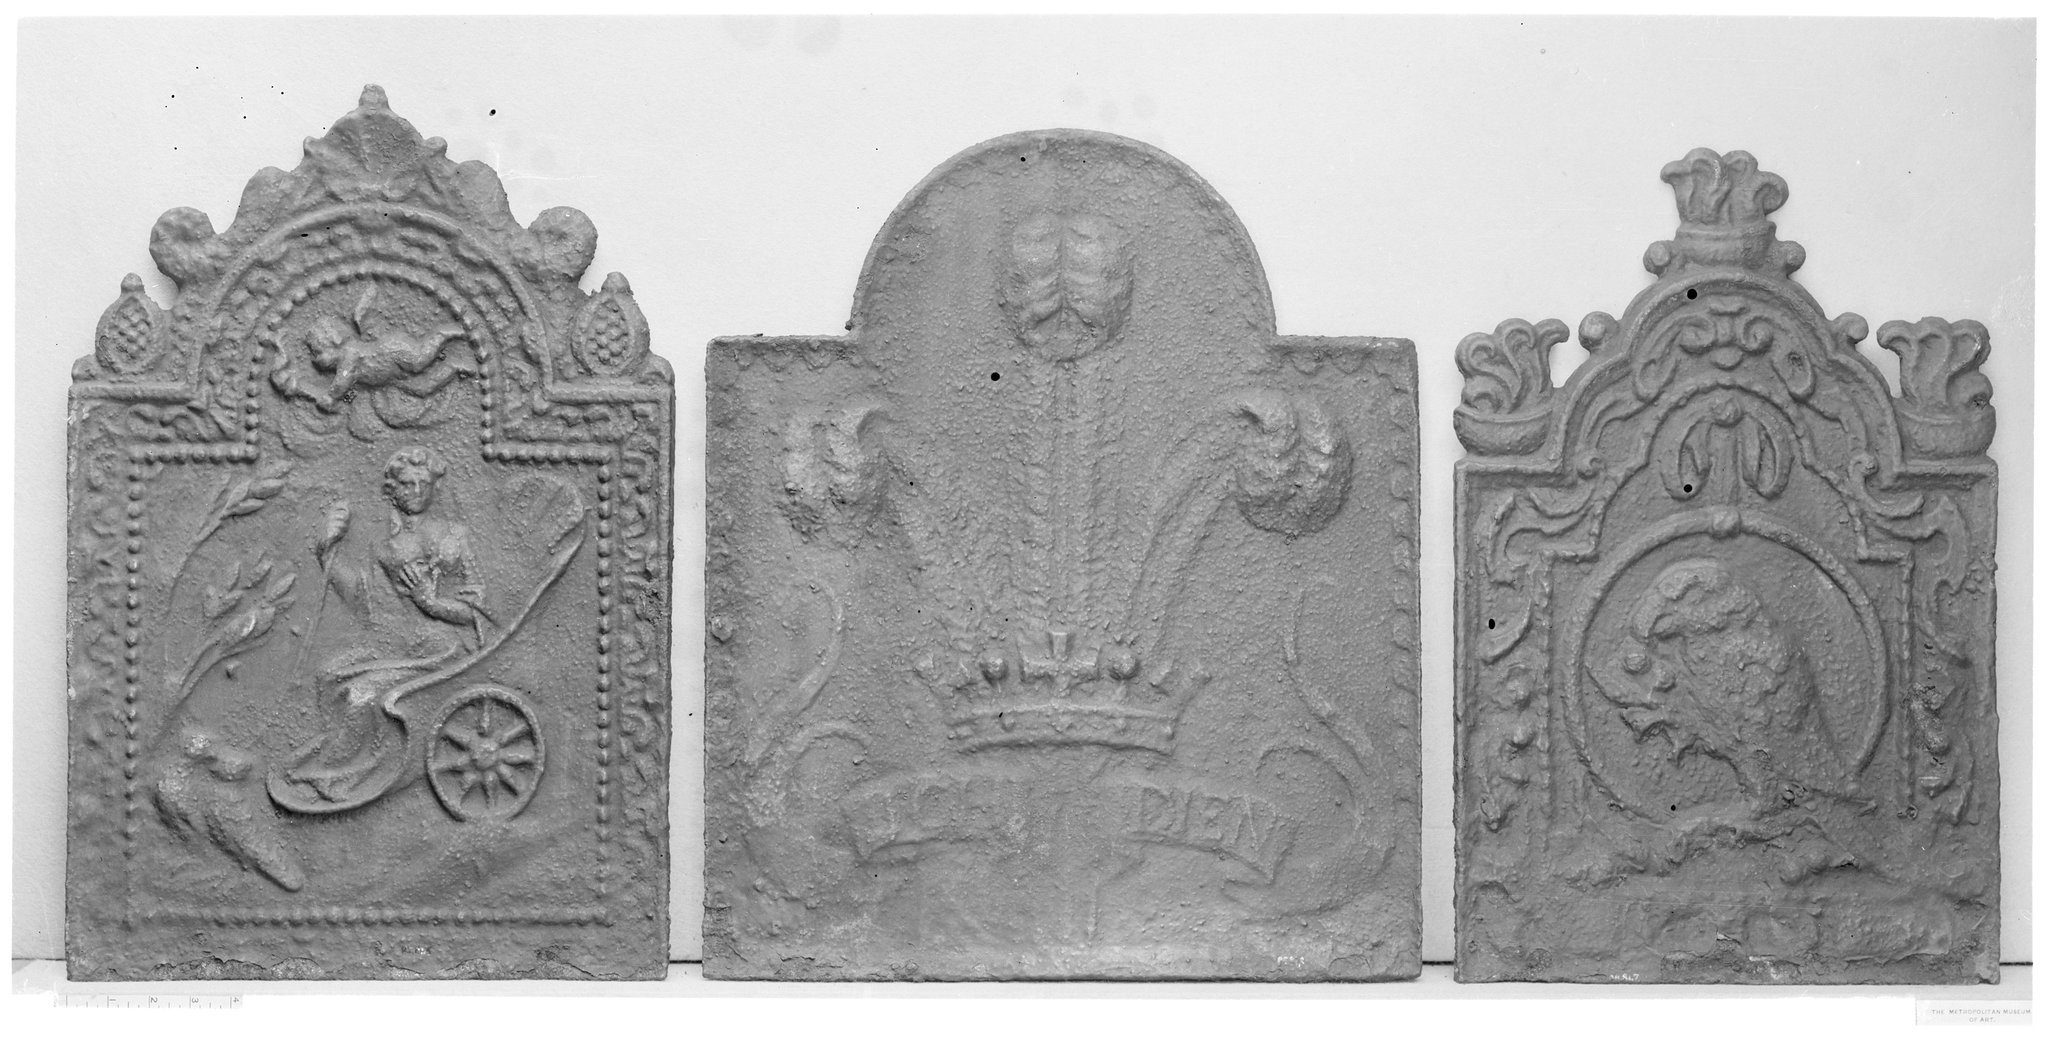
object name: fireback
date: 1601-1700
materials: iron